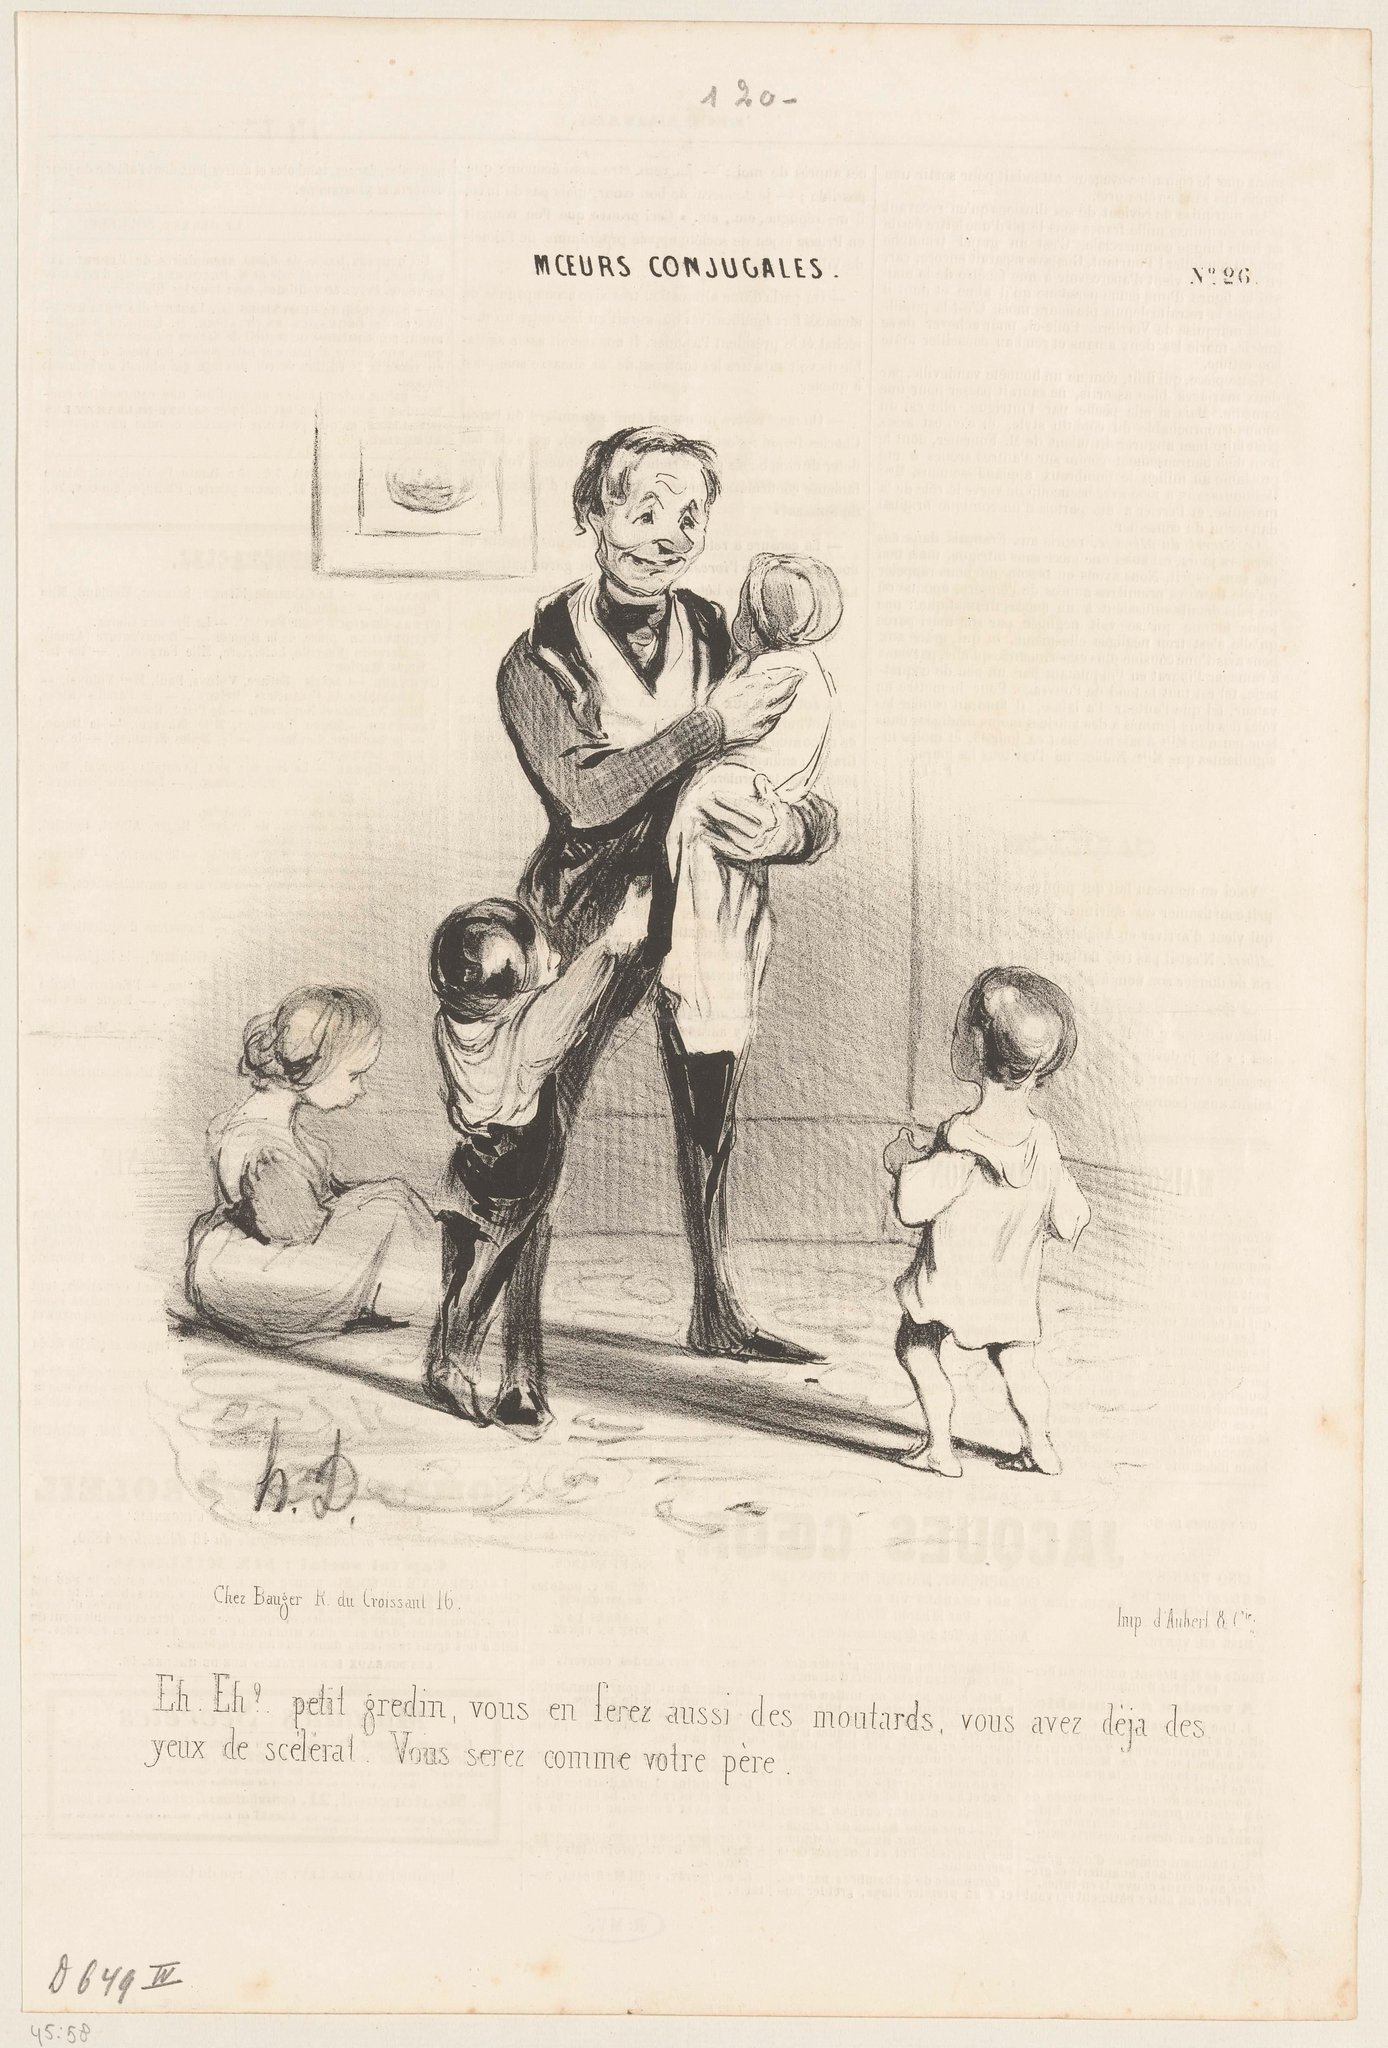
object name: cartoon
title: Gezinssituaties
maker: honoré daumier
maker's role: draughtsman, painter, print maker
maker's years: 1808-1879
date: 1840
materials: paper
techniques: letterpress printing, lithograph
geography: paris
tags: father with son(s) and daughter(s) (father-love), caricatures (human types), father and child(ren), man and child(ren) (family group) (with number of children)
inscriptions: collector's mark: Lugt 2228a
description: Prent mogelijk uit: Le Charivari, 5 juli 1840.